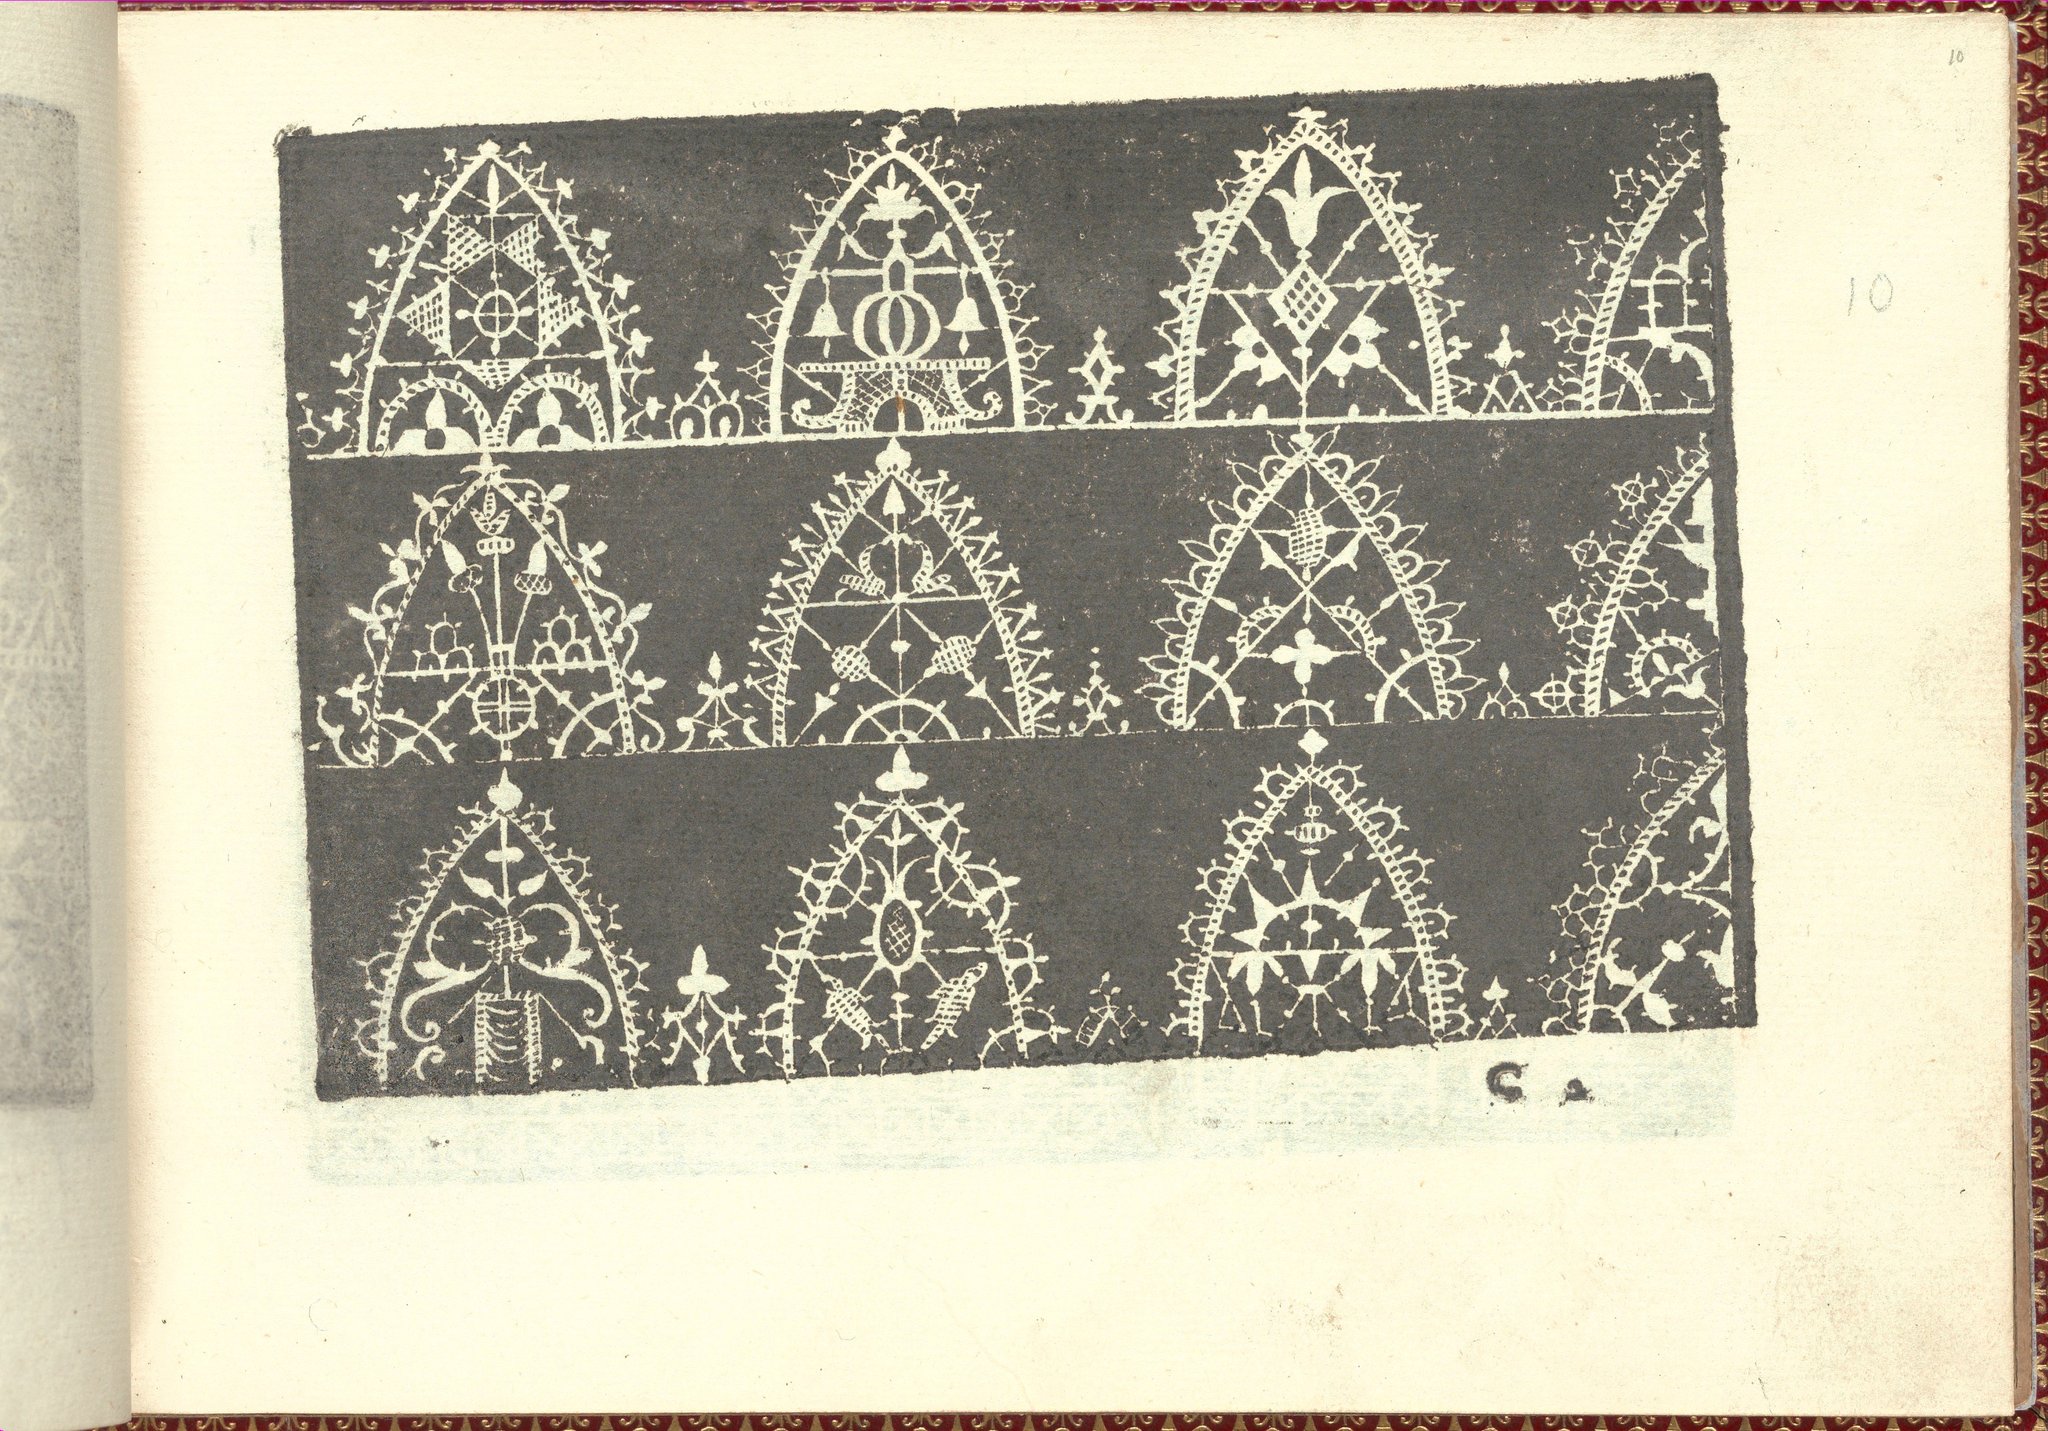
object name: book print ornament architecture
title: Corona delle Nobili et Virtuose Donne: Libro I-IV, page 10 (recto)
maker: cesare vecellio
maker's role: publisher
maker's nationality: italian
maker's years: 1521-1601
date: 1601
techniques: woodcut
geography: italy